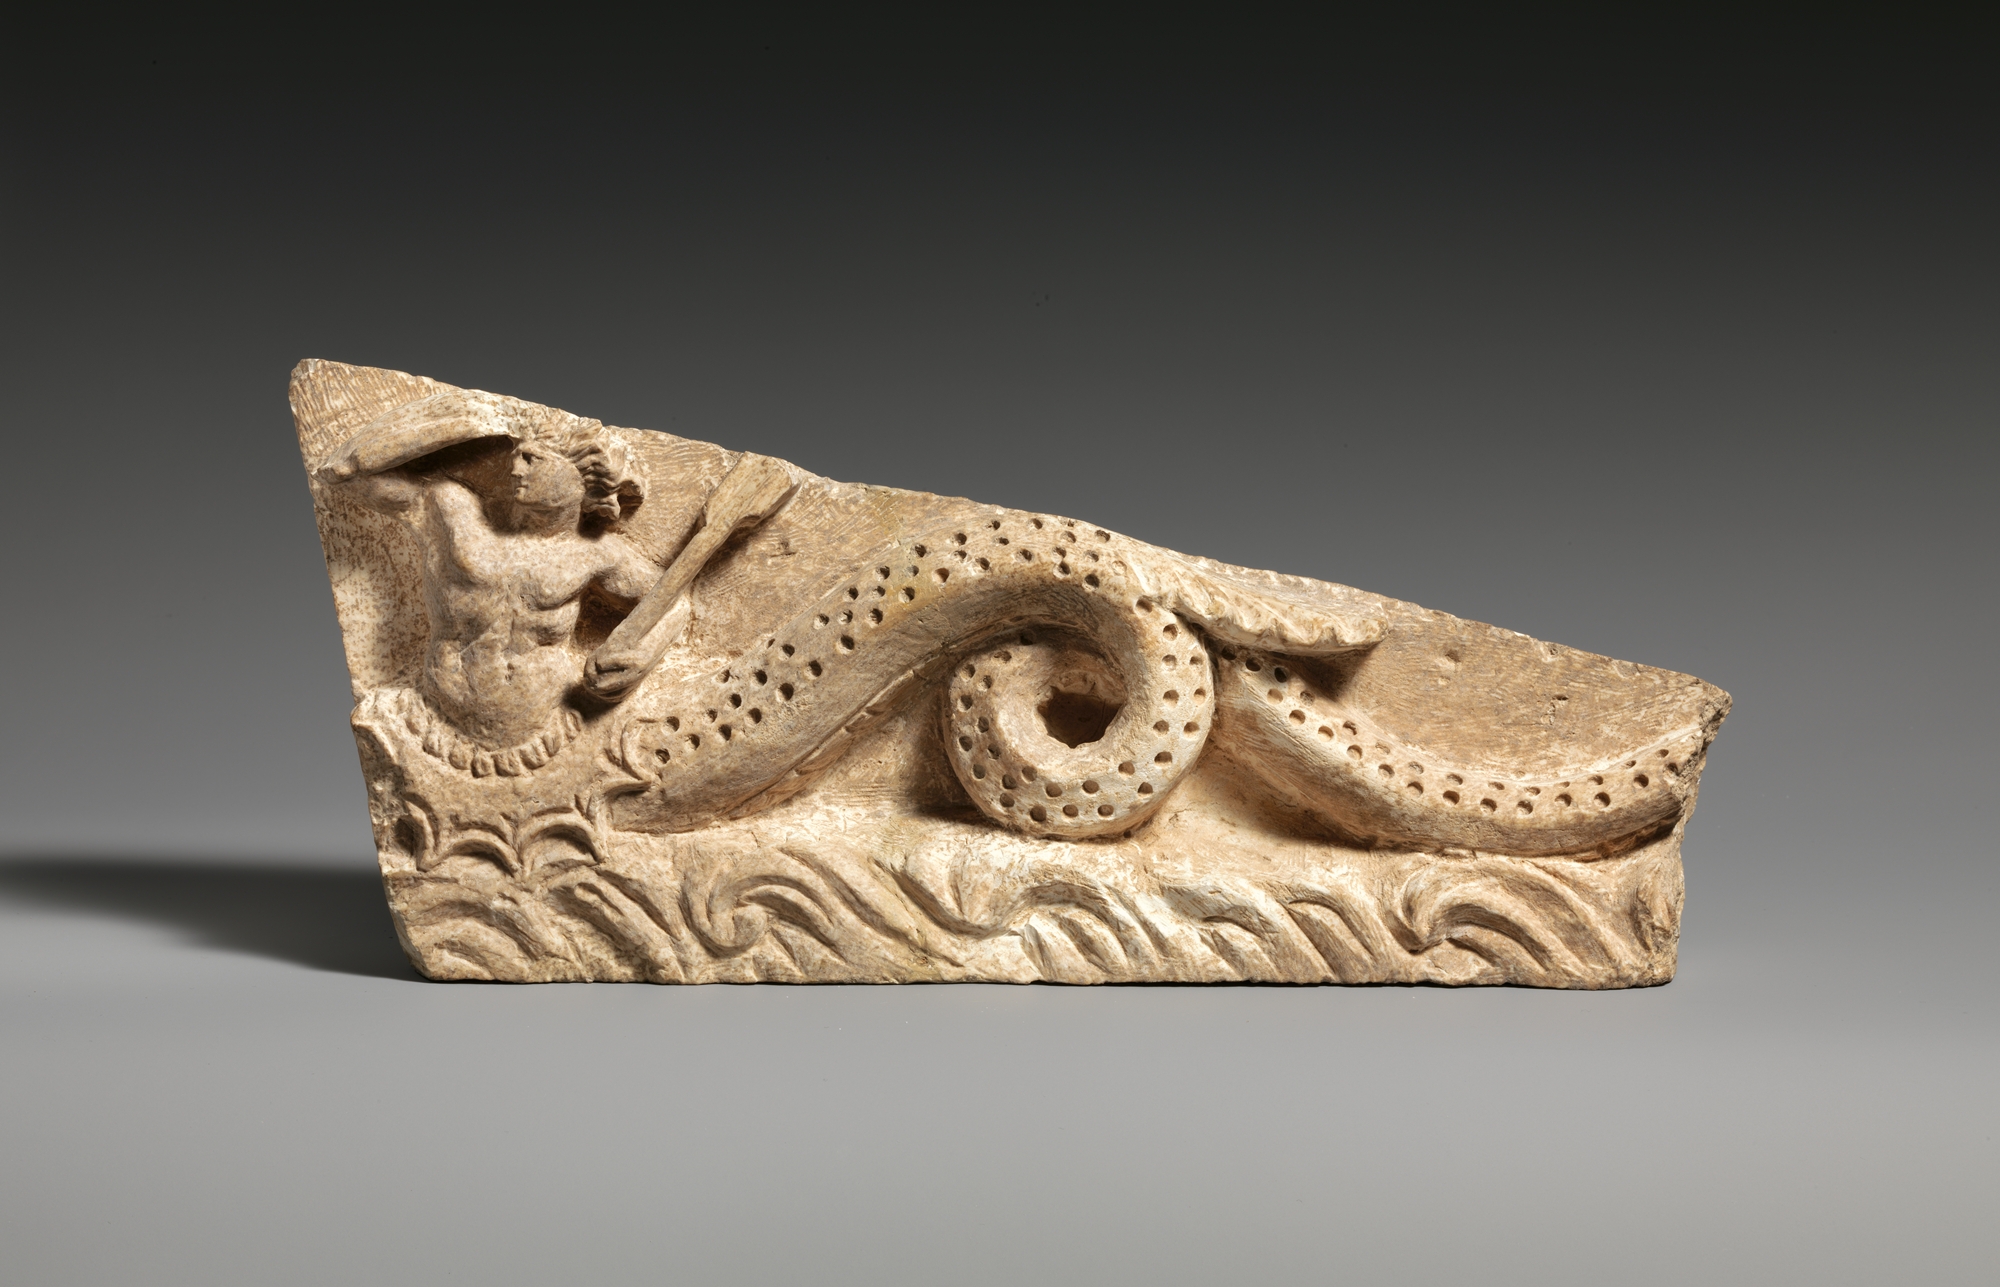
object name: relief pediment, sea monster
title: Limestone pediment fragment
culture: greek, south italian, tarentine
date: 300 BCE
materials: limestone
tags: monsters